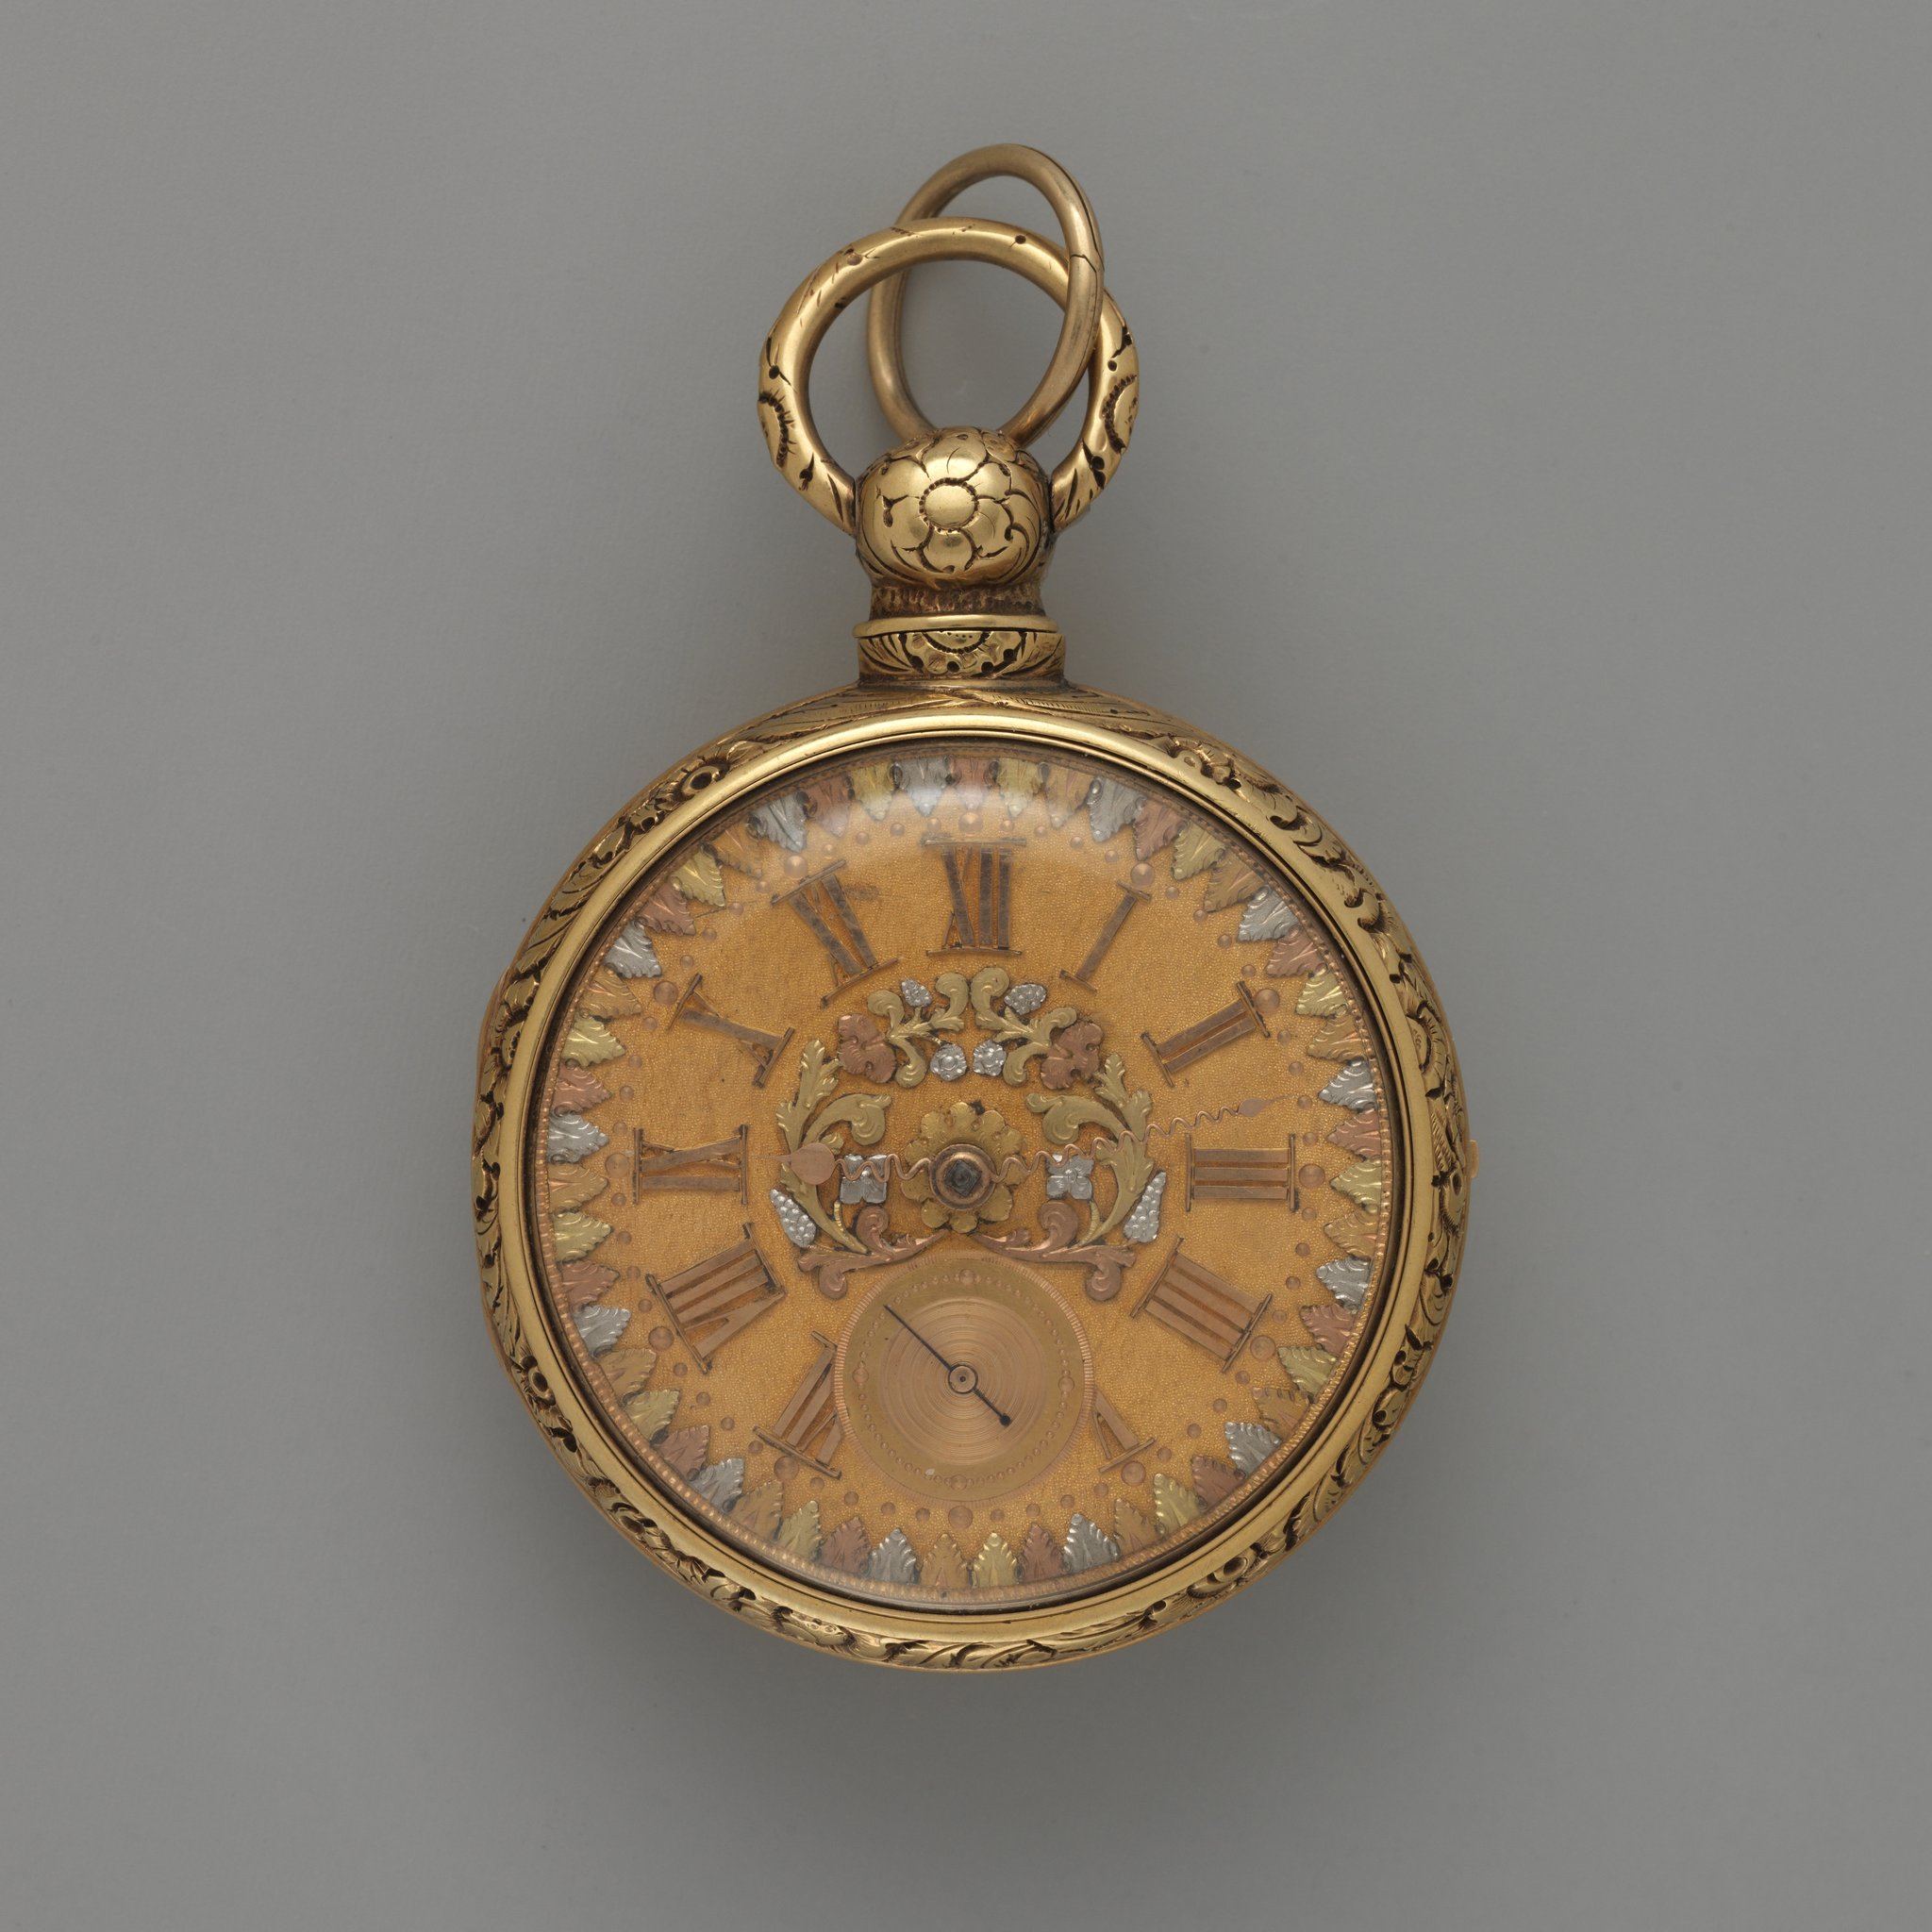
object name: pair case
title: Pair-case watch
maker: s. i. tobias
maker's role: maker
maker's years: 1808-1825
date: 1824-1825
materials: gold